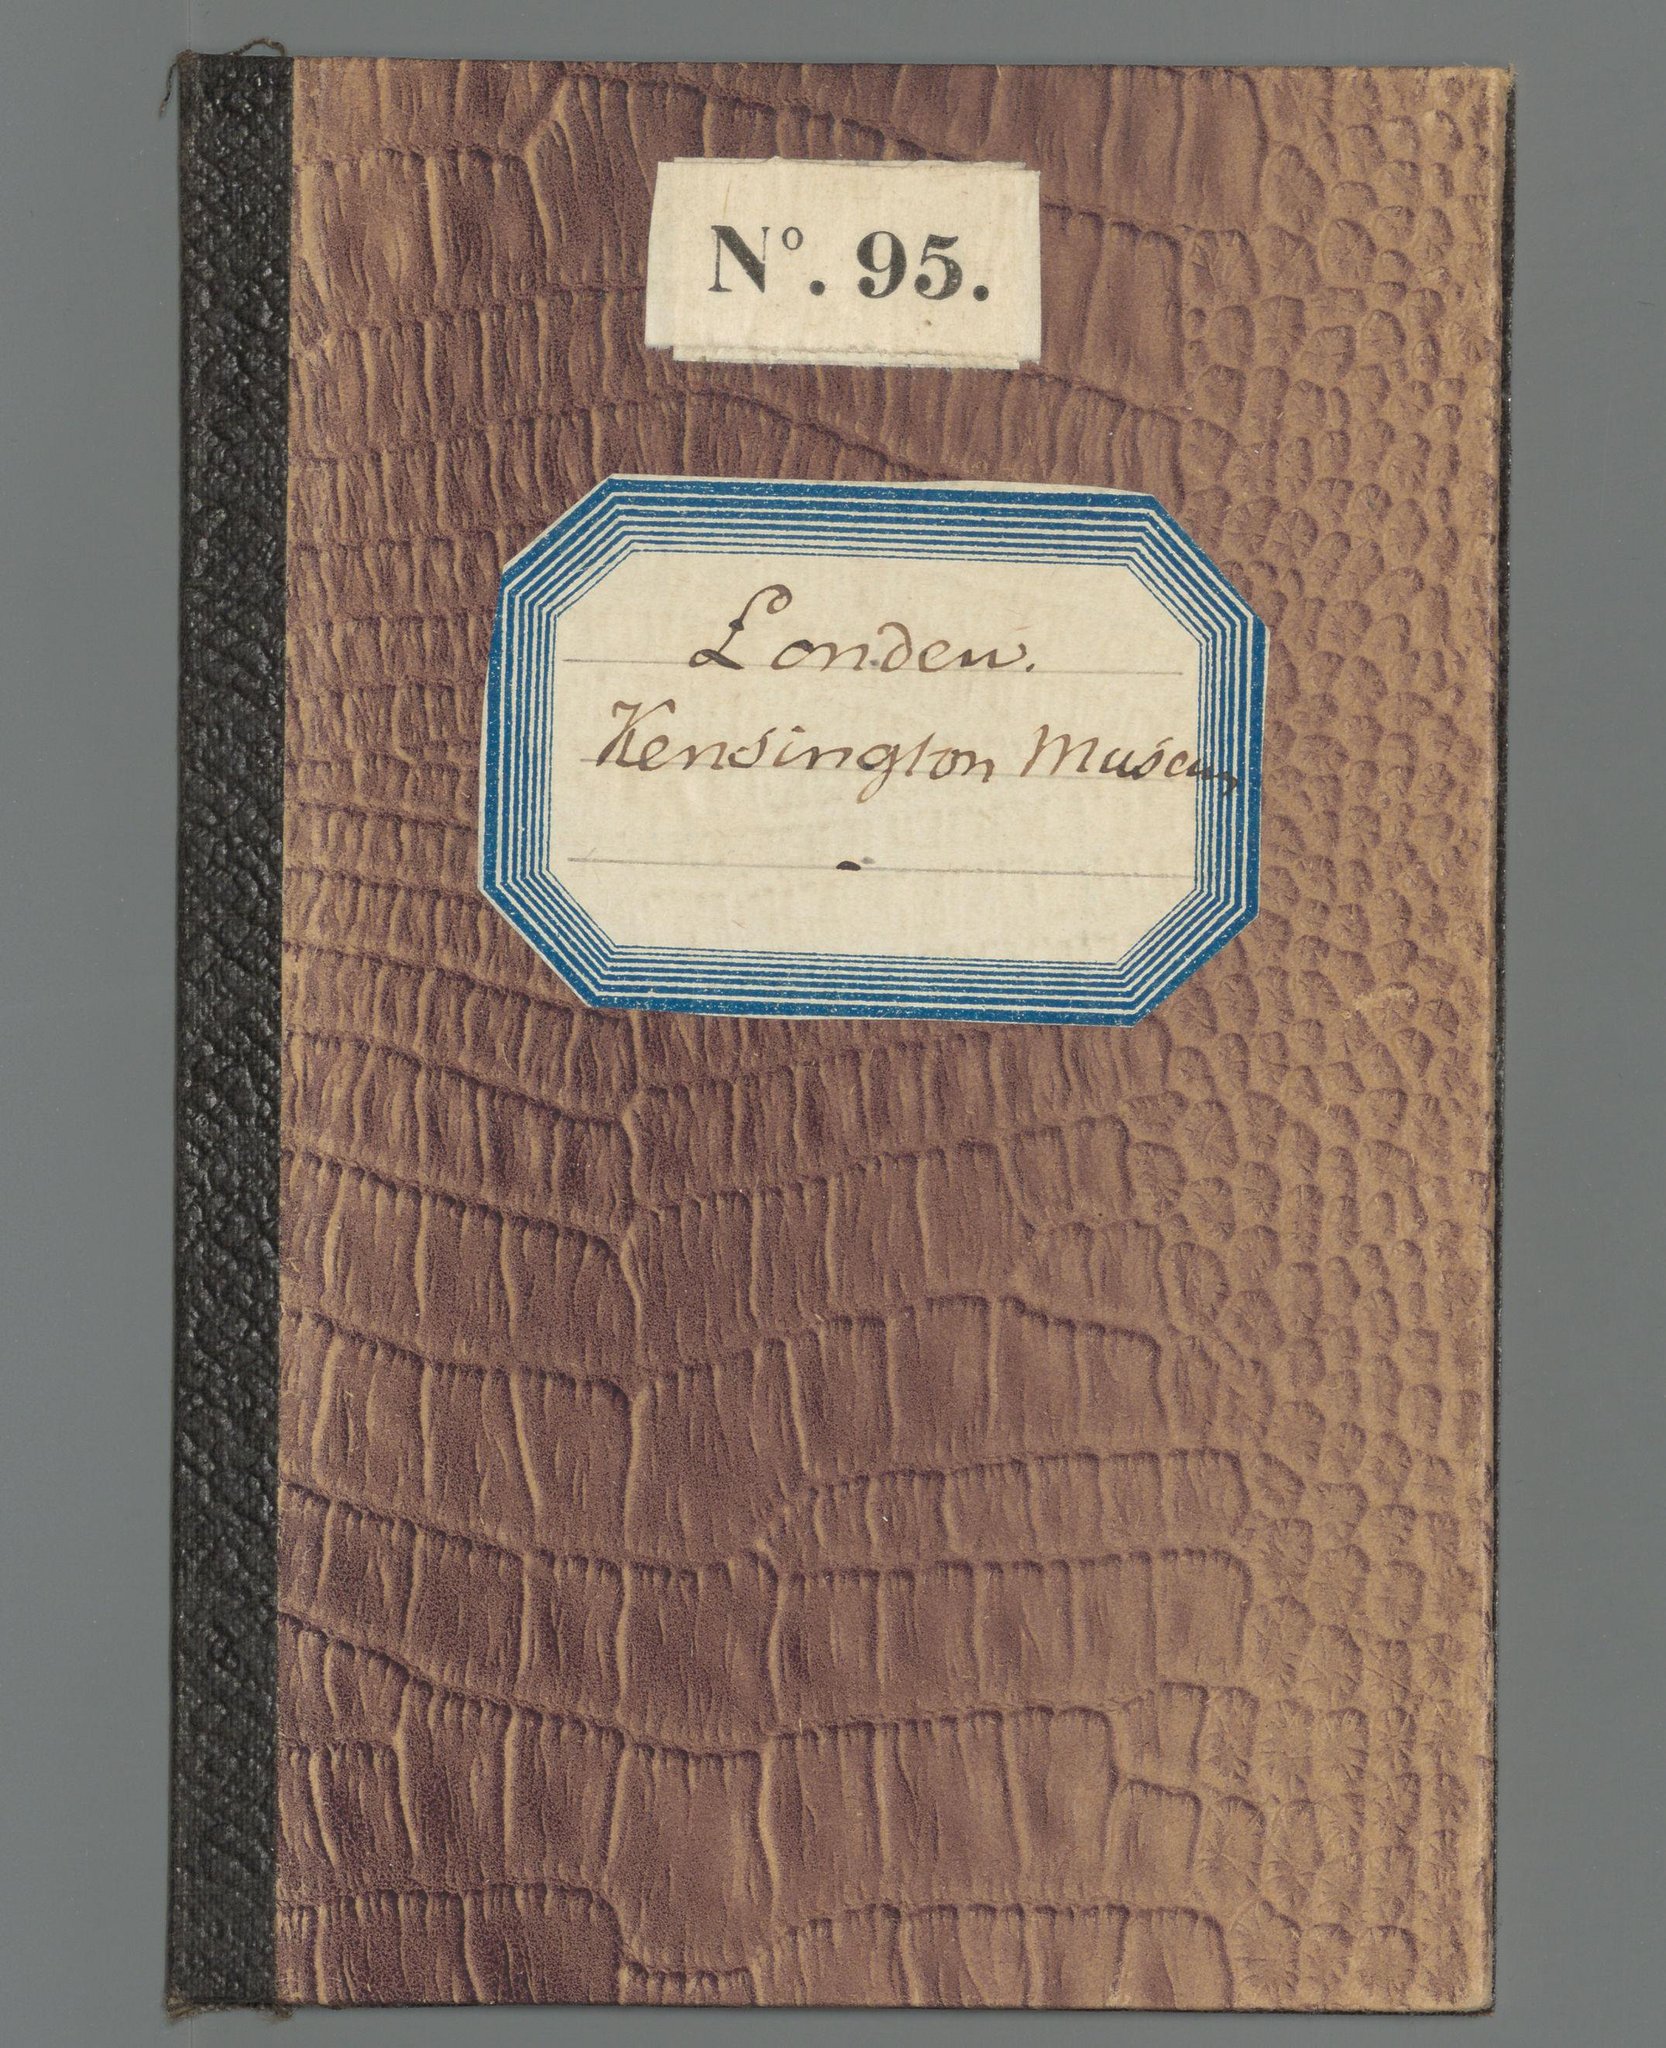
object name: wrapper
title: Londen. Kensington Museum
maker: Anonymous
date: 1900-1950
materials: cardboard, paper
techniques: lithograph, writing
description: In de omslag zit een kaart ingestoken met daarop een korte beschrijving van de inhoud.